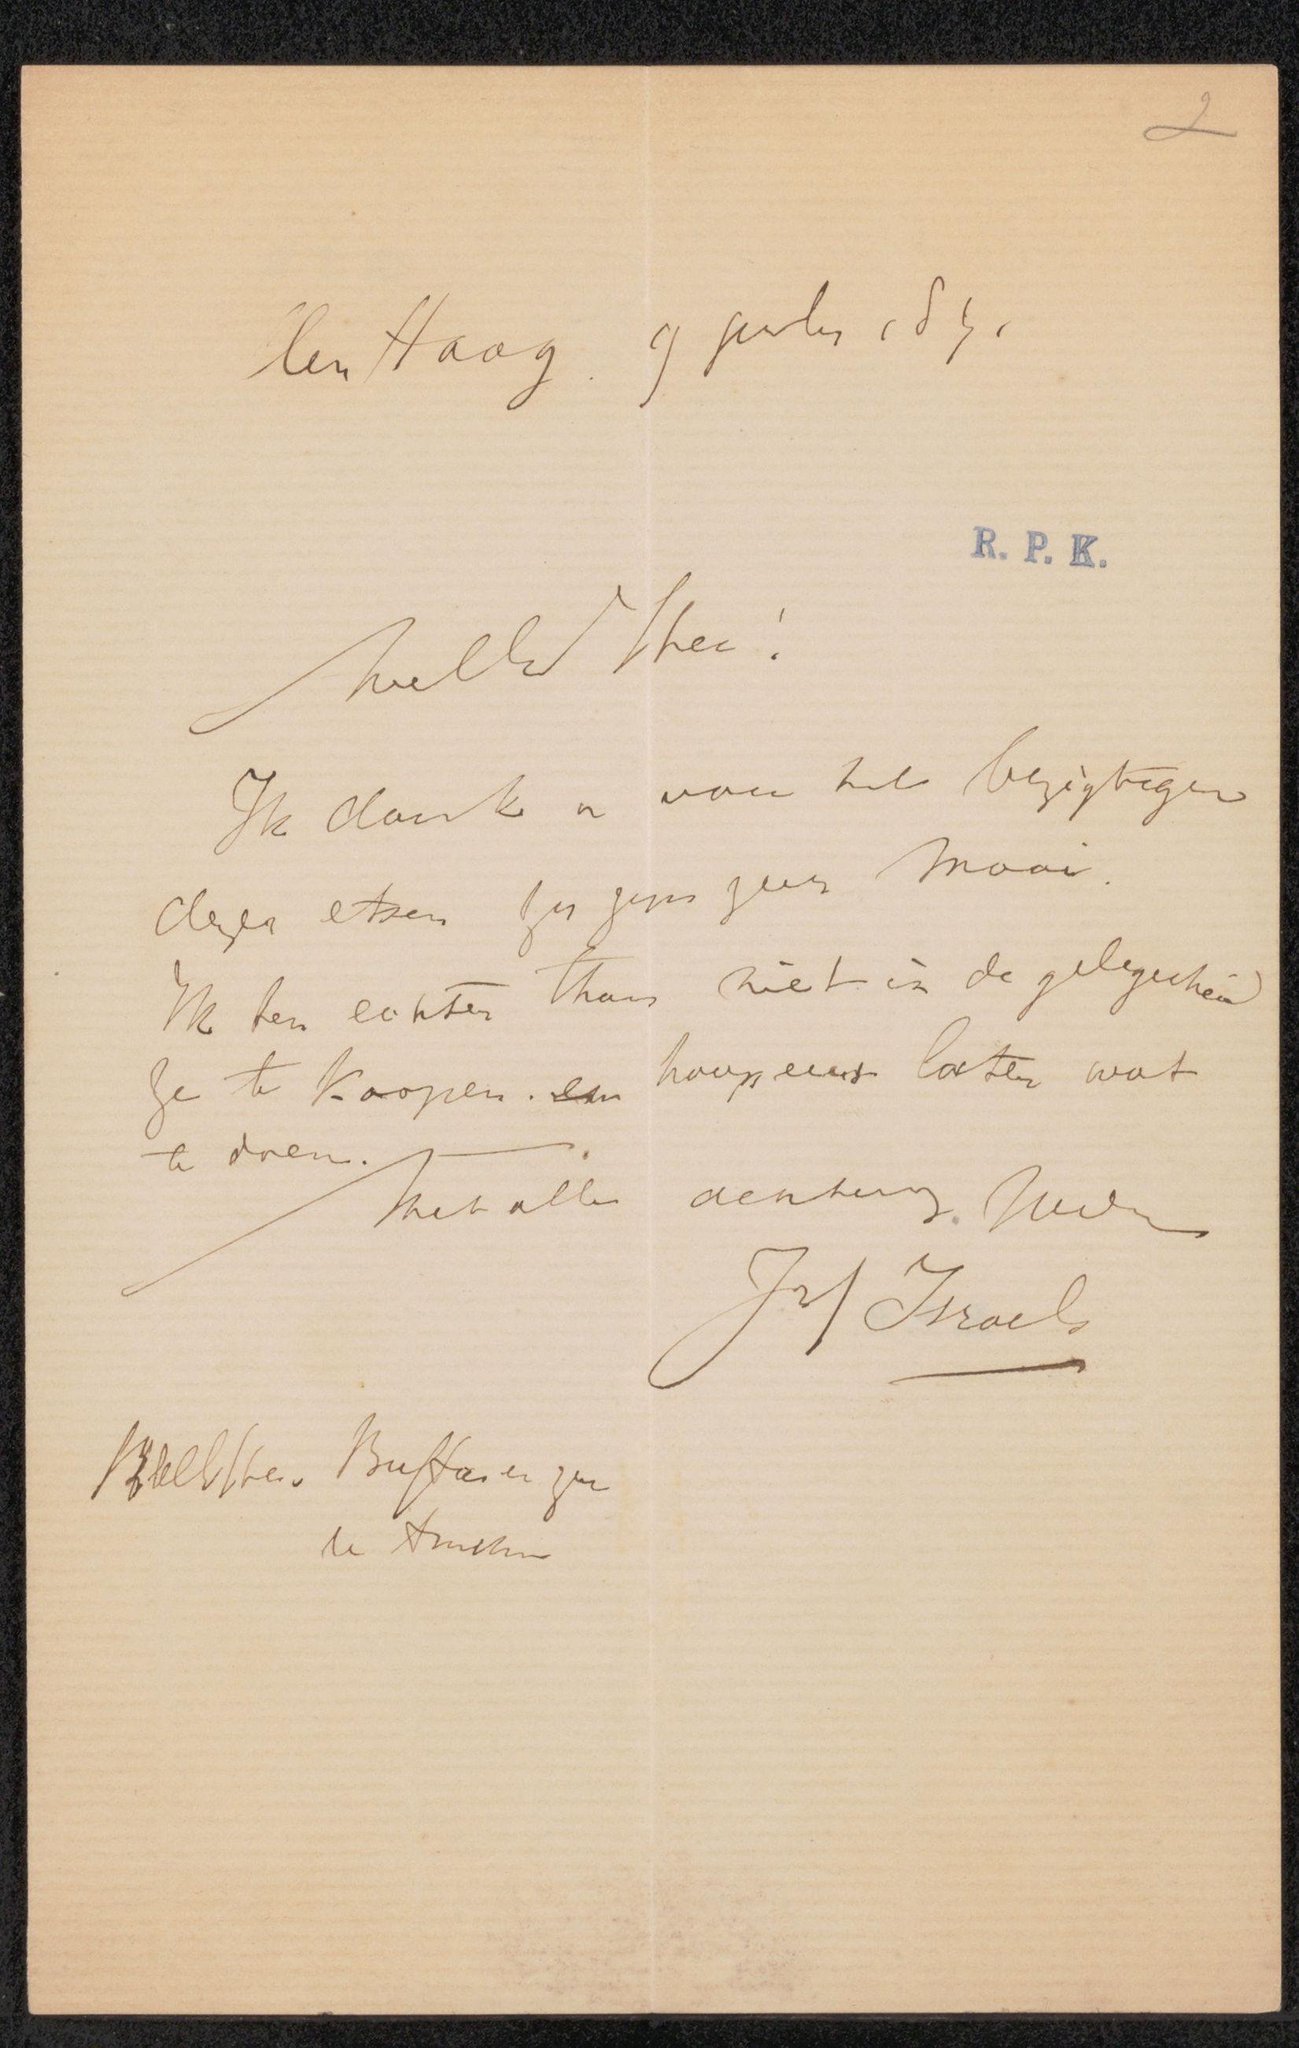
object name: letter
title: Brief aan Frans Buffa en Zonen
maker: jozef israëls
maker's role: draughtsman, painter, print maker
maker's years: 1824-1911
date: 1871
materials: ink, paper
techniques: pen, writing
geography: the hague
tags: publisher, art trade, art shop, the graphic arts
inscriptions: collector's mark: Lugt 2233